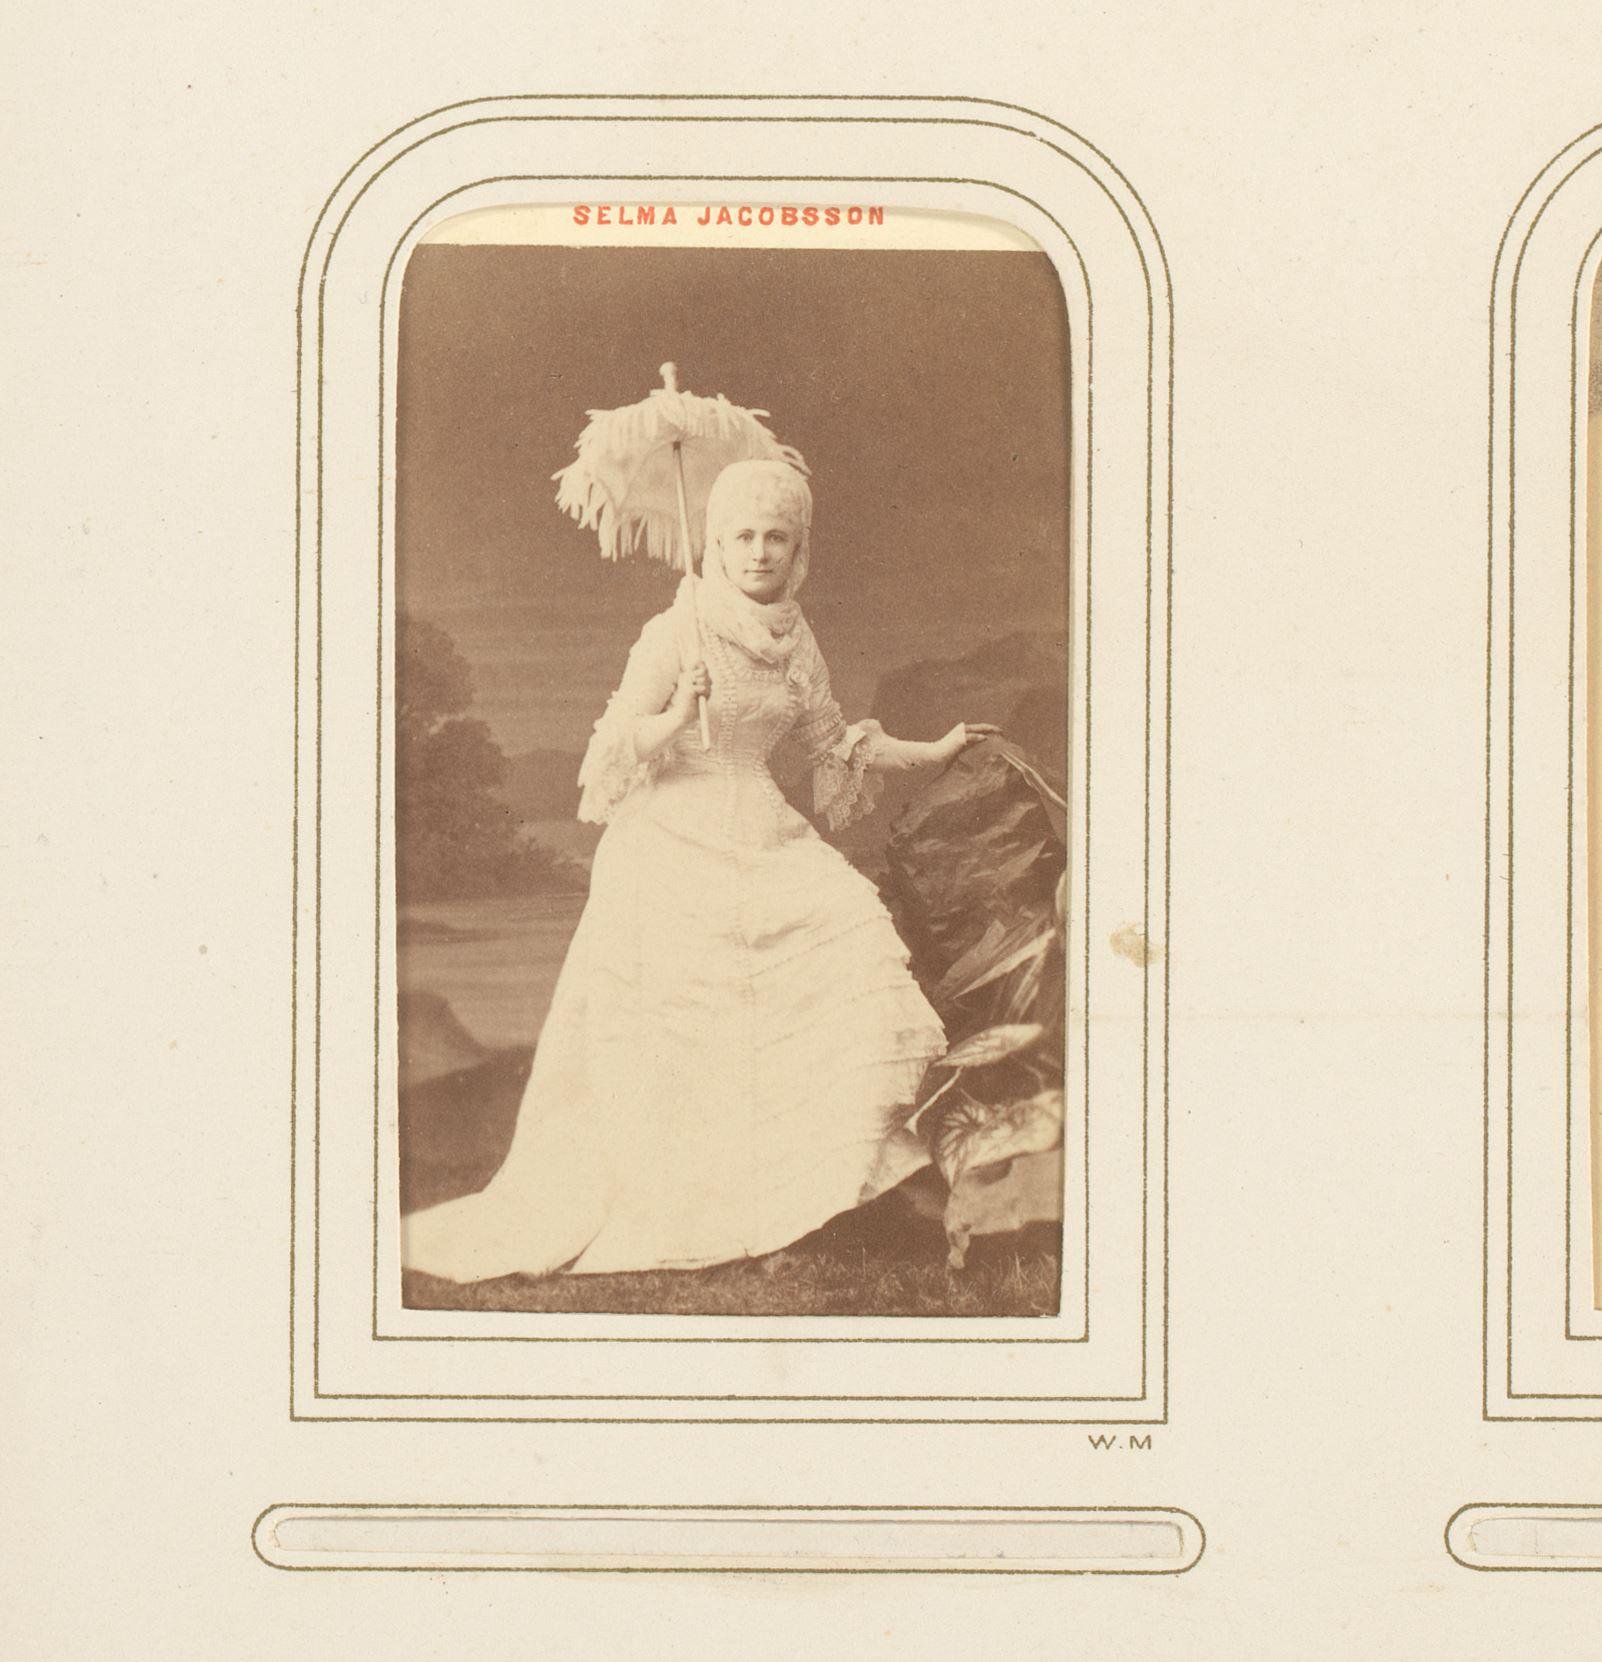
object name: carte de visite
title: Portret van Gurli Åberg met parasol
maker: selma jacobsson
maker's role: fotograaf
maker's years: 1841-1899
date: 1860-1880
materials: cardboard, photographic support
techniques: albumen print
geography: stockholm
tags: historical persons - bb - woman, portrait of actor, actress, parasol, sunshade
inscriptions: inscription: ‘Selma Jacobsson/ Stockholm/ Fredsgatan No 15’, annotation: ‘Gurli Ulff/ b. Åberg/ 1843 - 1922’